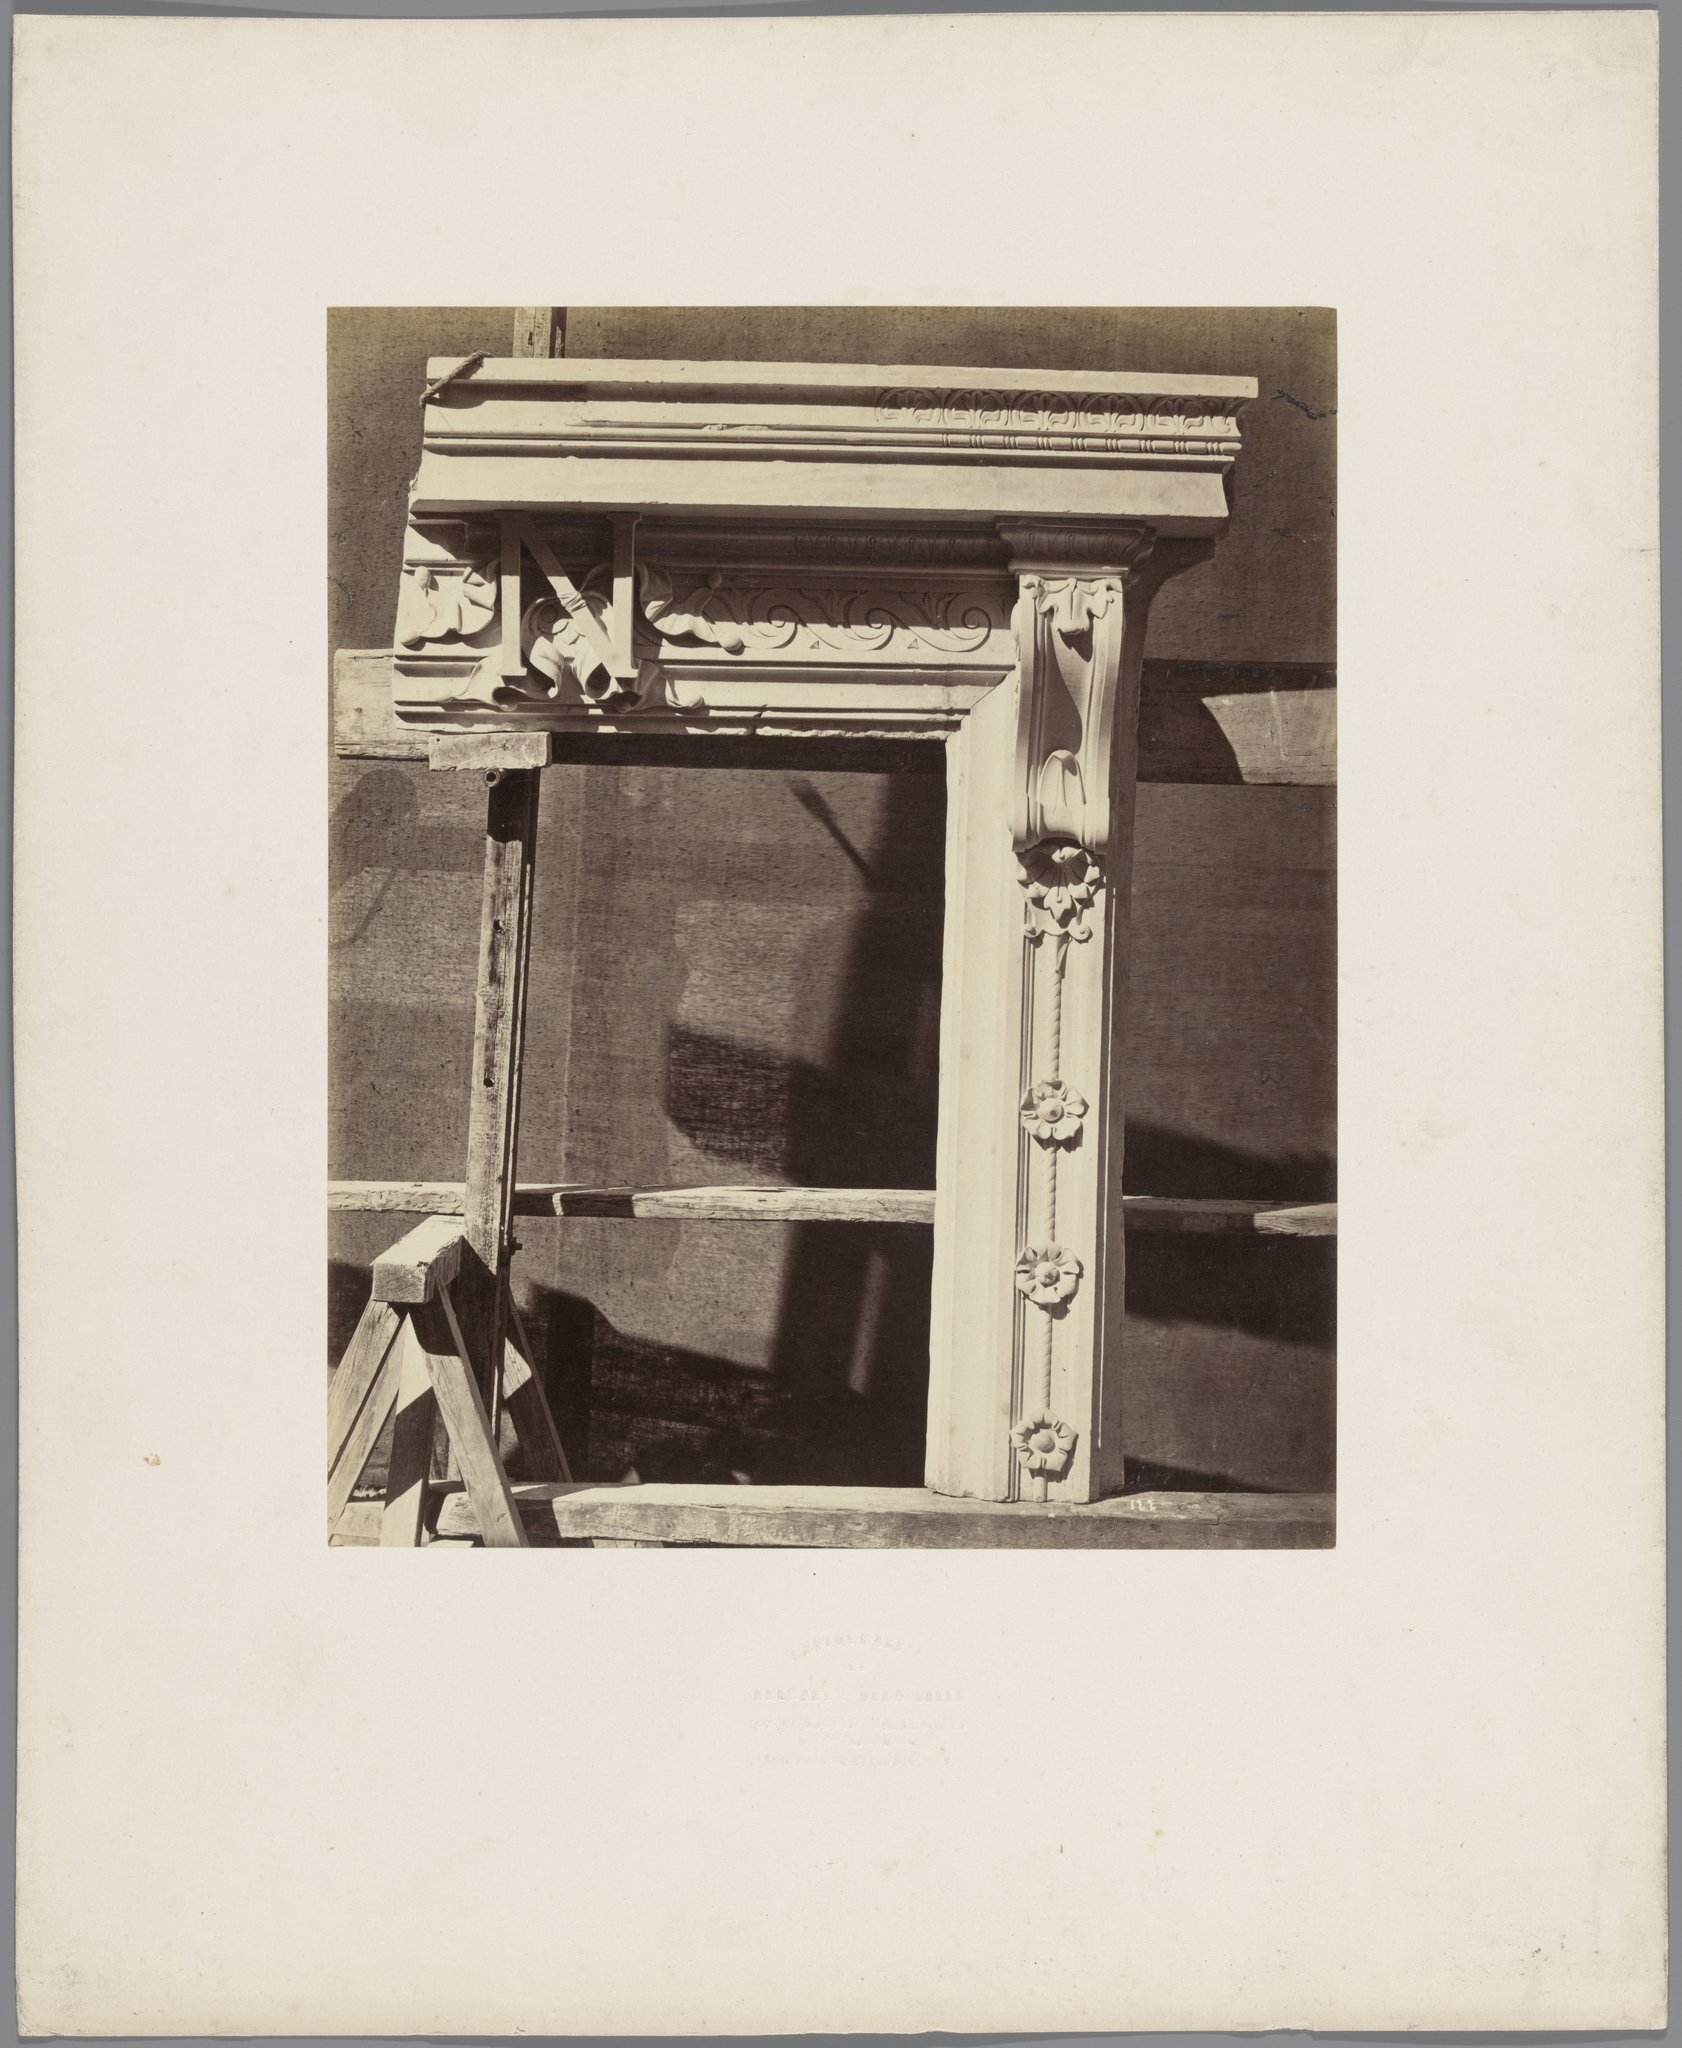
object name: photograph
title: Architectural Fragment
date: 1862-1868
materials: cardboard, paper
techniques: albumen print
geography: paris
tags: architectural detail, paris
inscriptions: address: ‘22, B. des Filles du Calvaire’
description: Paris was radically rebuilt in the second half of the 19th century. Along with scores of new streets, many new buildings were erected, including the Nouvel Opéra, Sacré-Coeur, and the Eiffel Tower. The Paris firm of Delmaet et Durandelle, specialized in architectural photography, followed the progress of all three buildings. They also photographed individual details one by one.